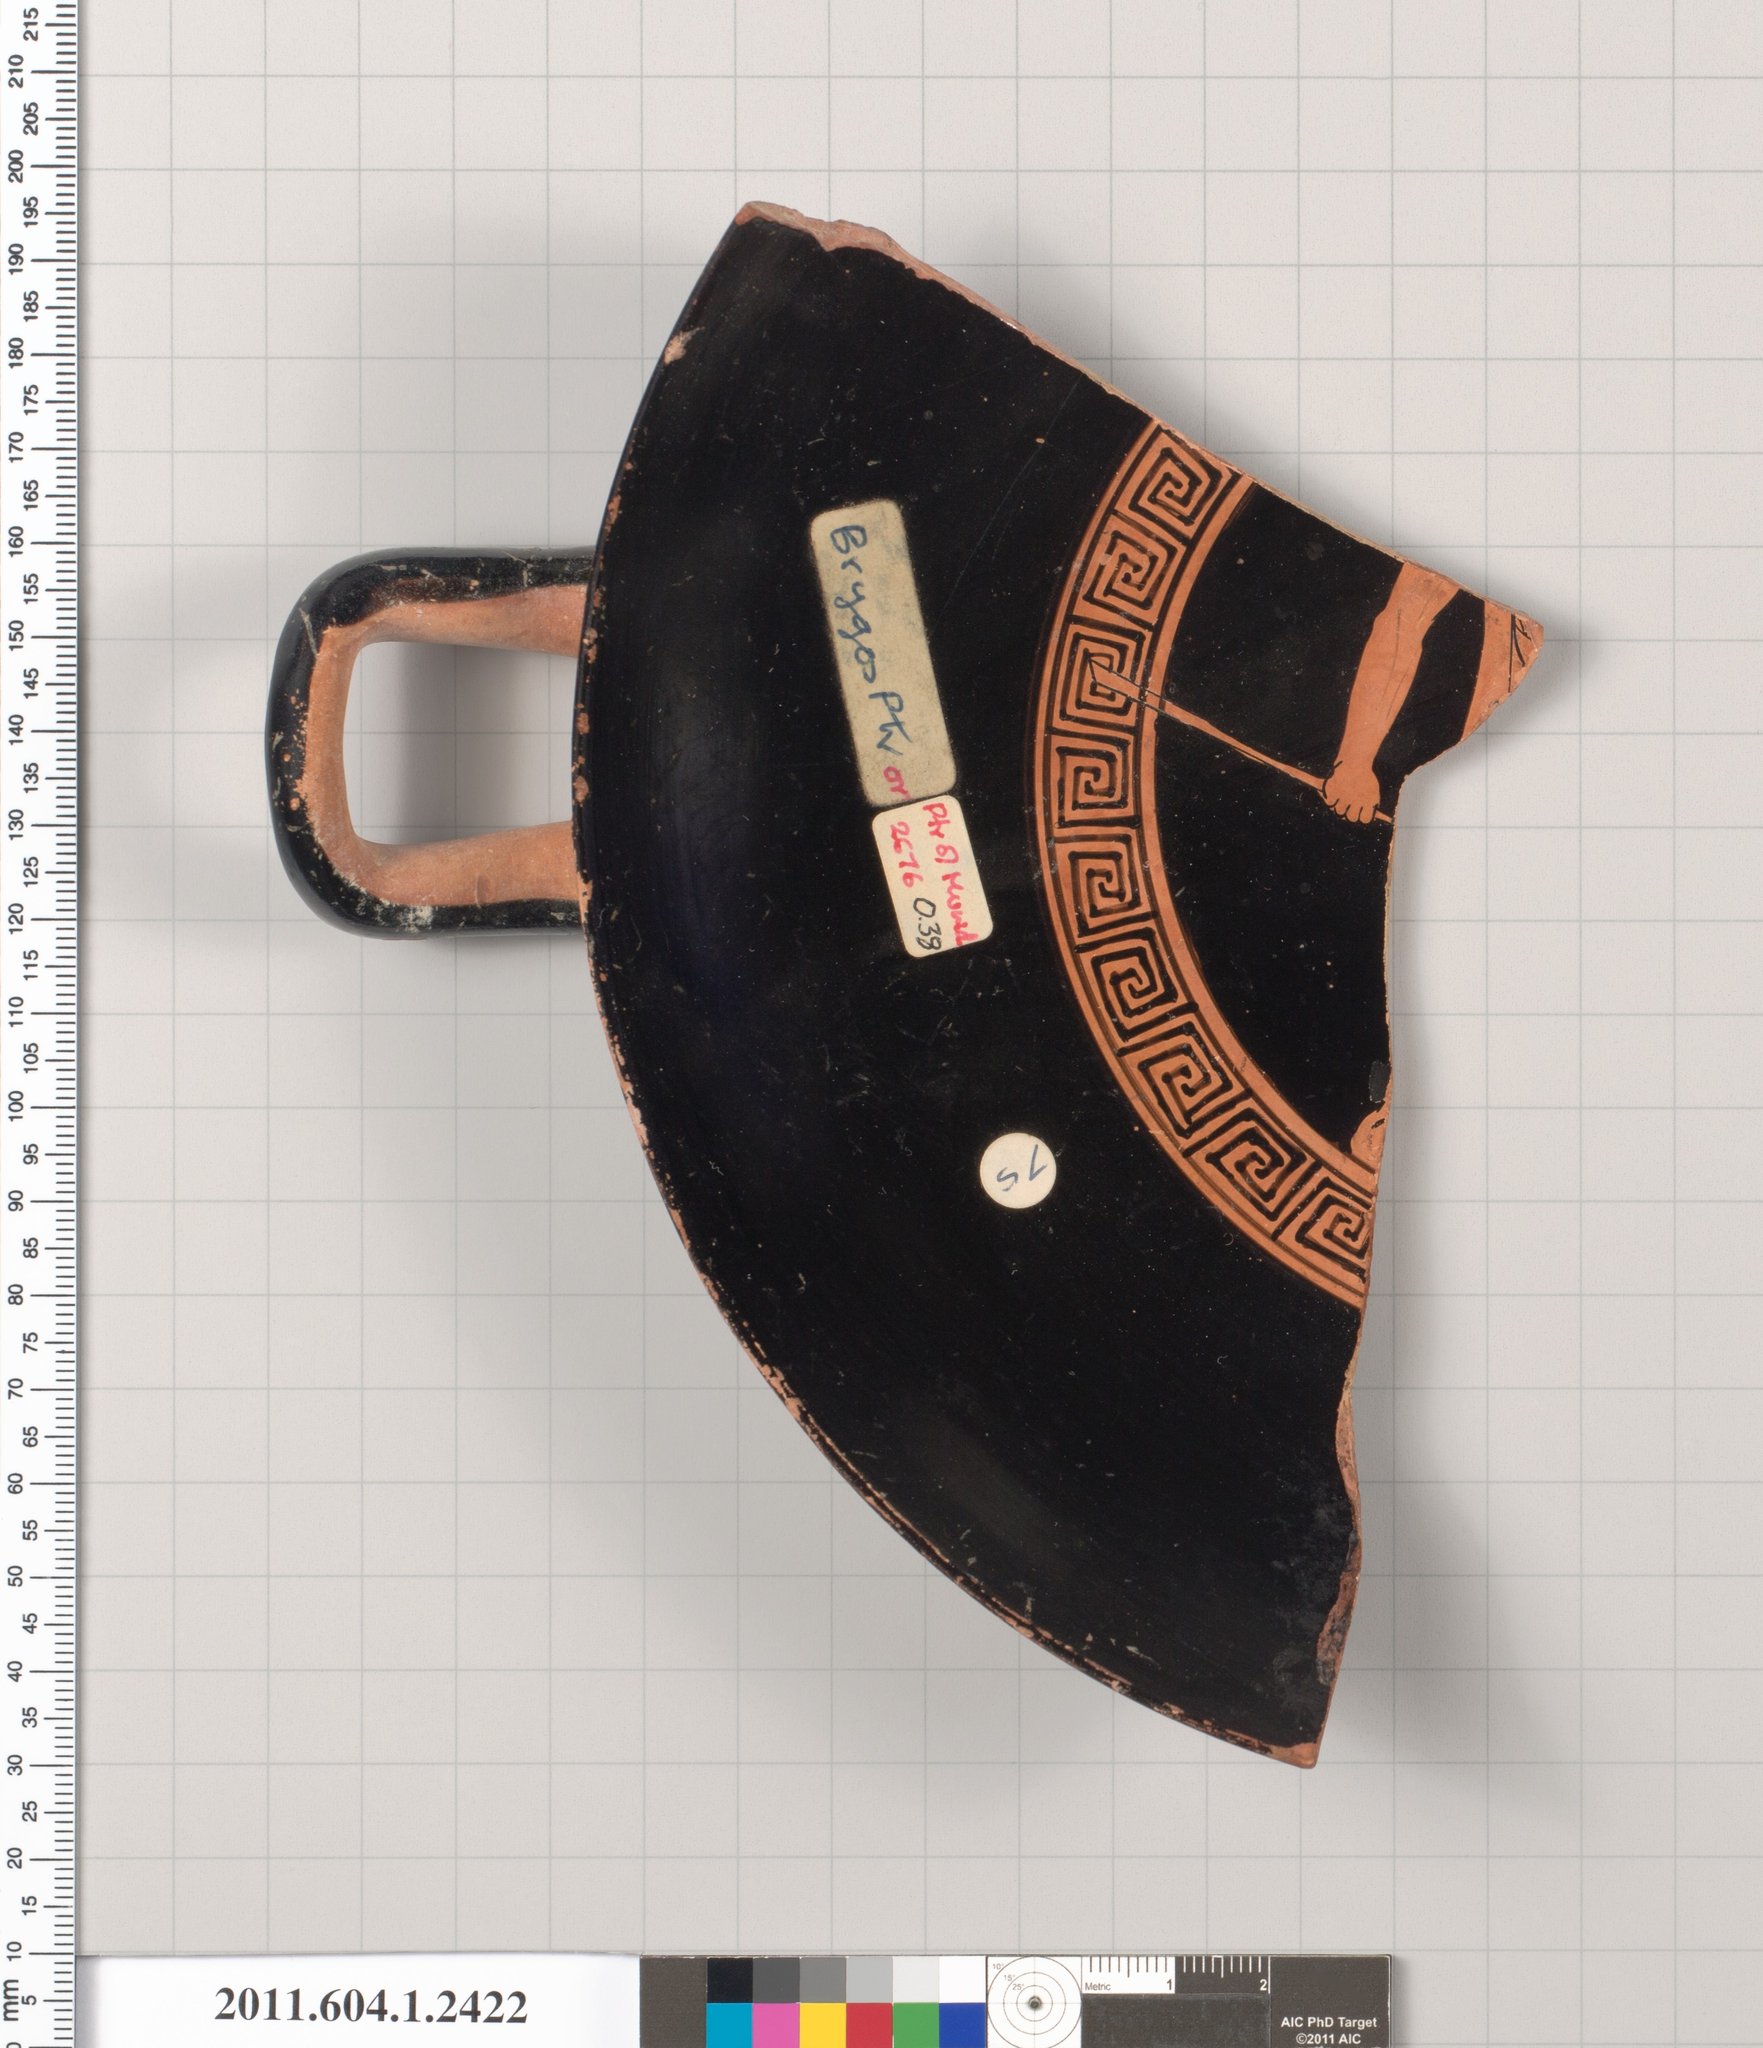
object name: kylix fragment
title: Terracotta fragment of a kylix (drinking cup)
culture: greek, attic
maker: brygos painter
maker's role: artist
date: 480-470 BCE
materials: terracotta